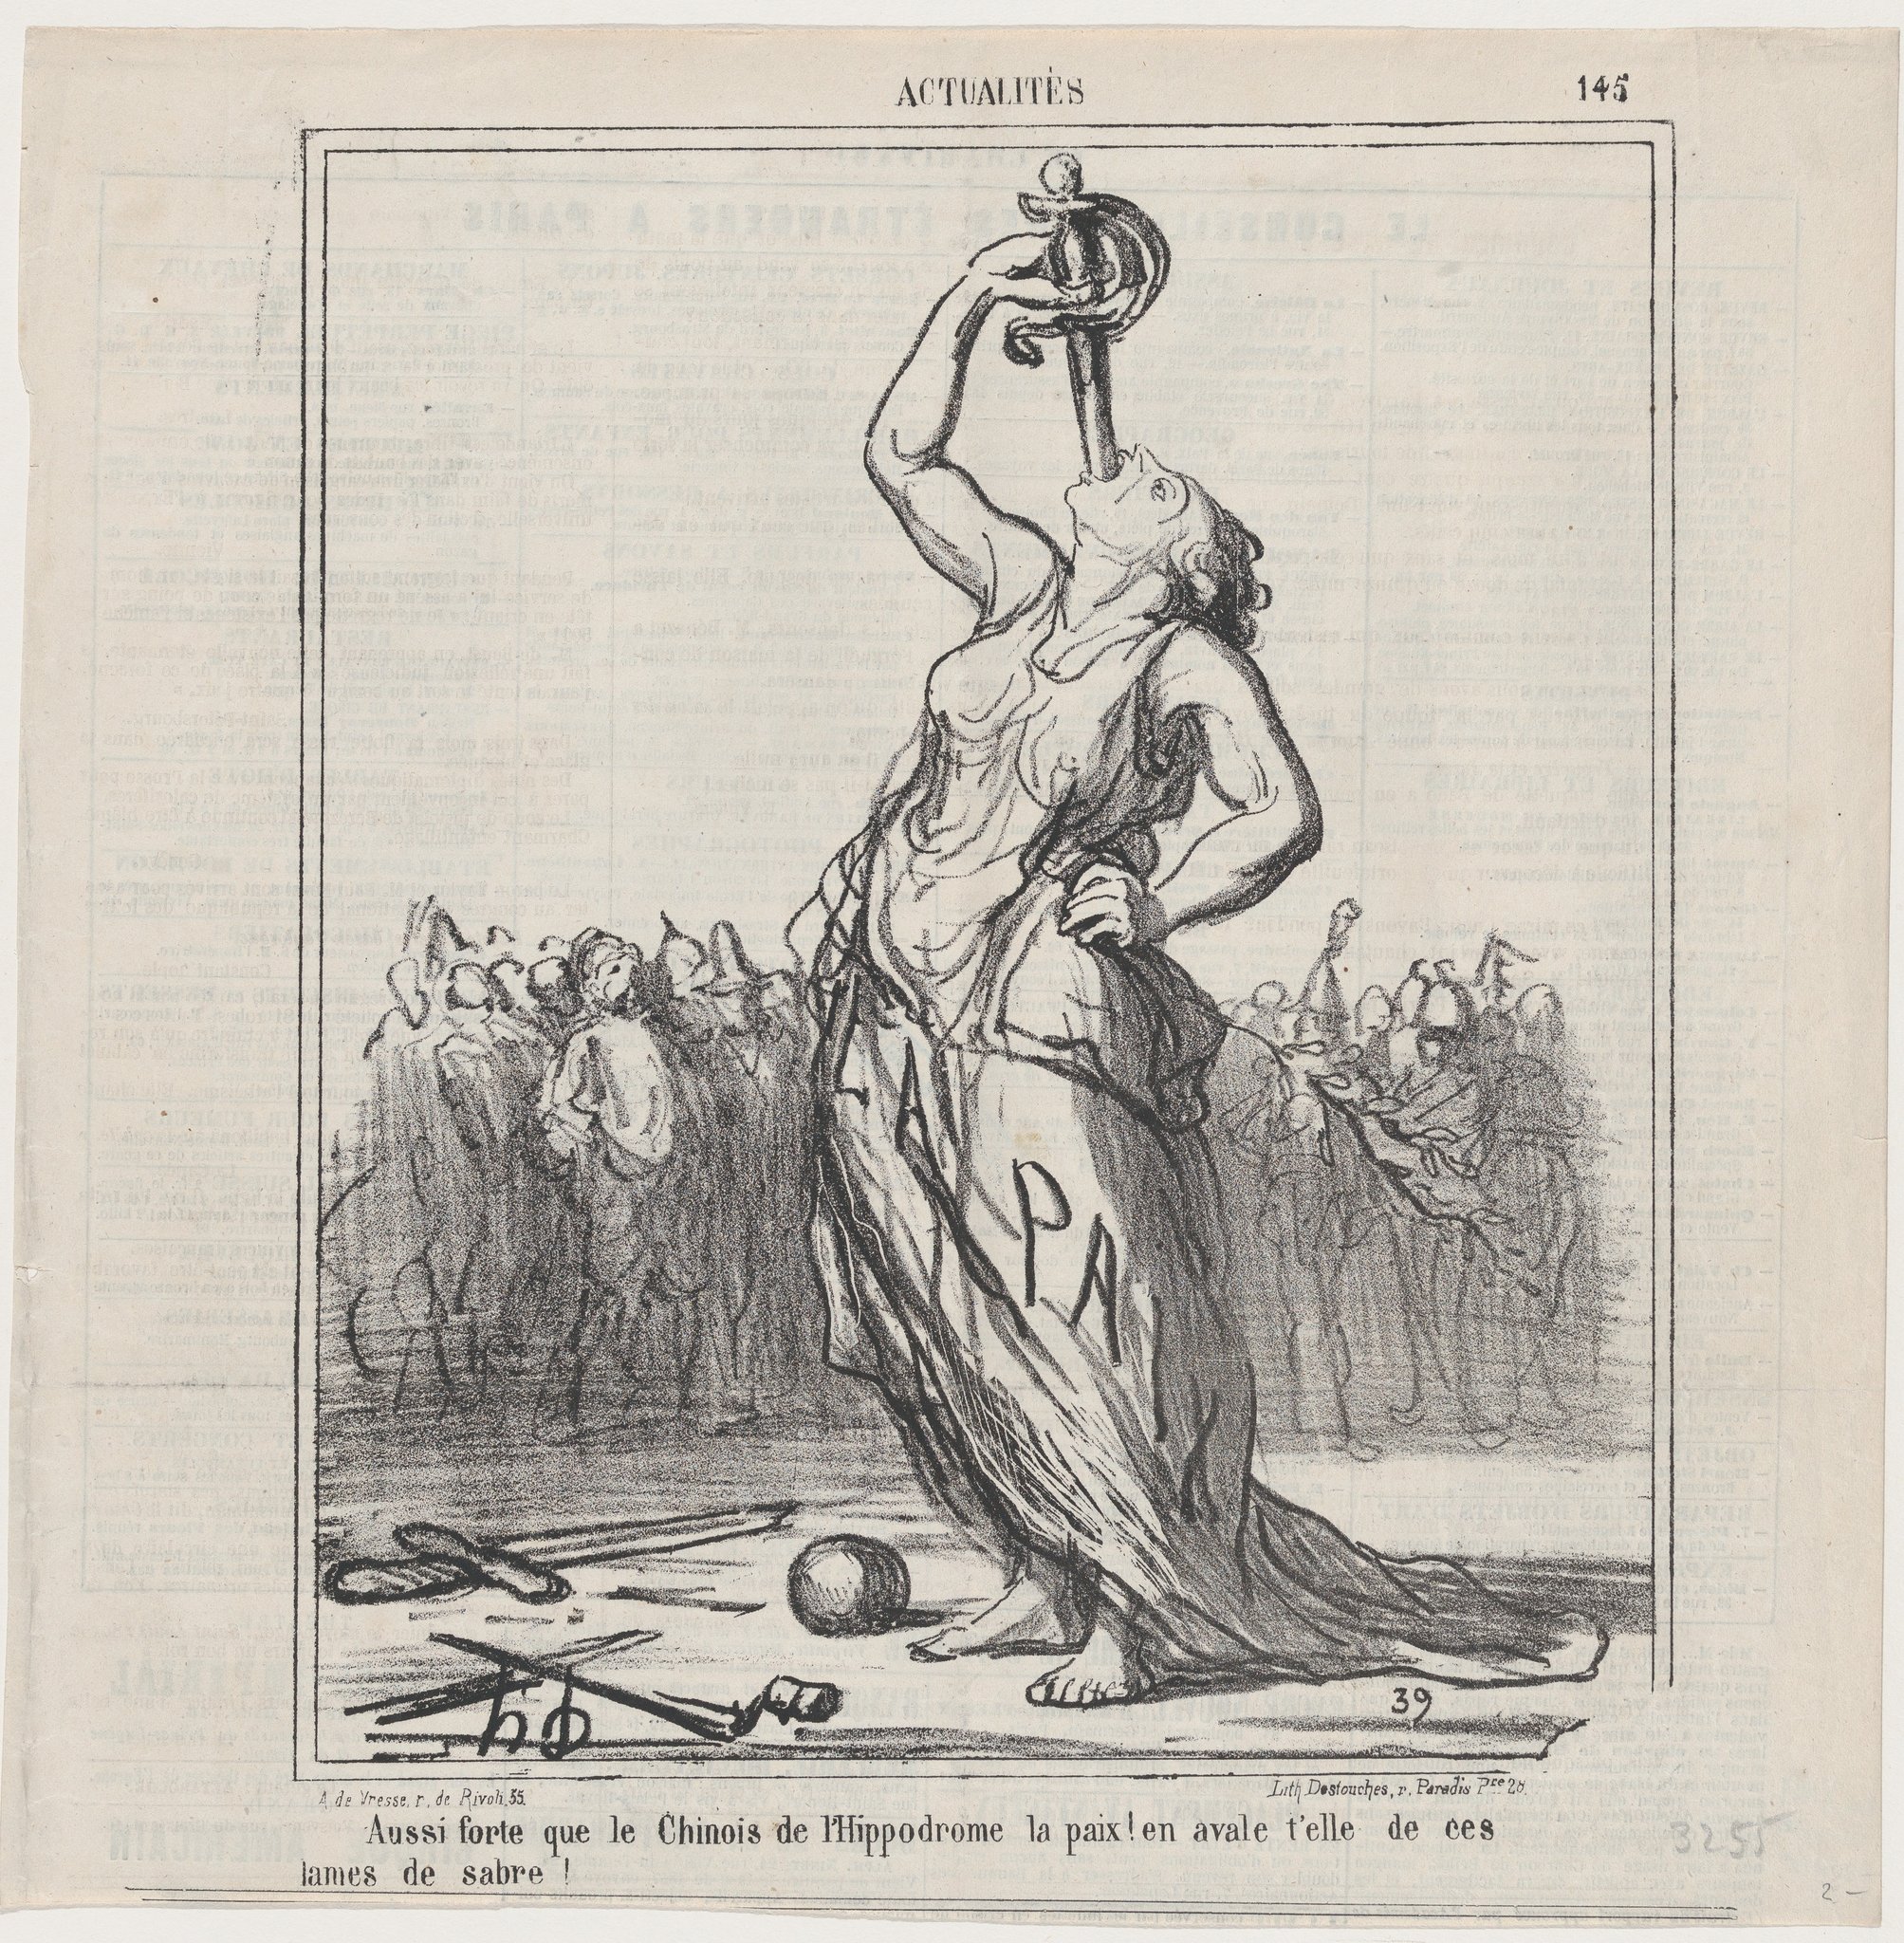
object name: print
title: Peace, as strong as the Chinese at the hippodrome... will she also be able to swallow sabre blades?, from 'News of the day,' published in "Le Charivari"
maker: honoré daumier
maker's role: artist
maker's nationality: french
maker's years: 1808-1879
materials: paper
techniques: lithograph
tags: performance,swords,women,crowd